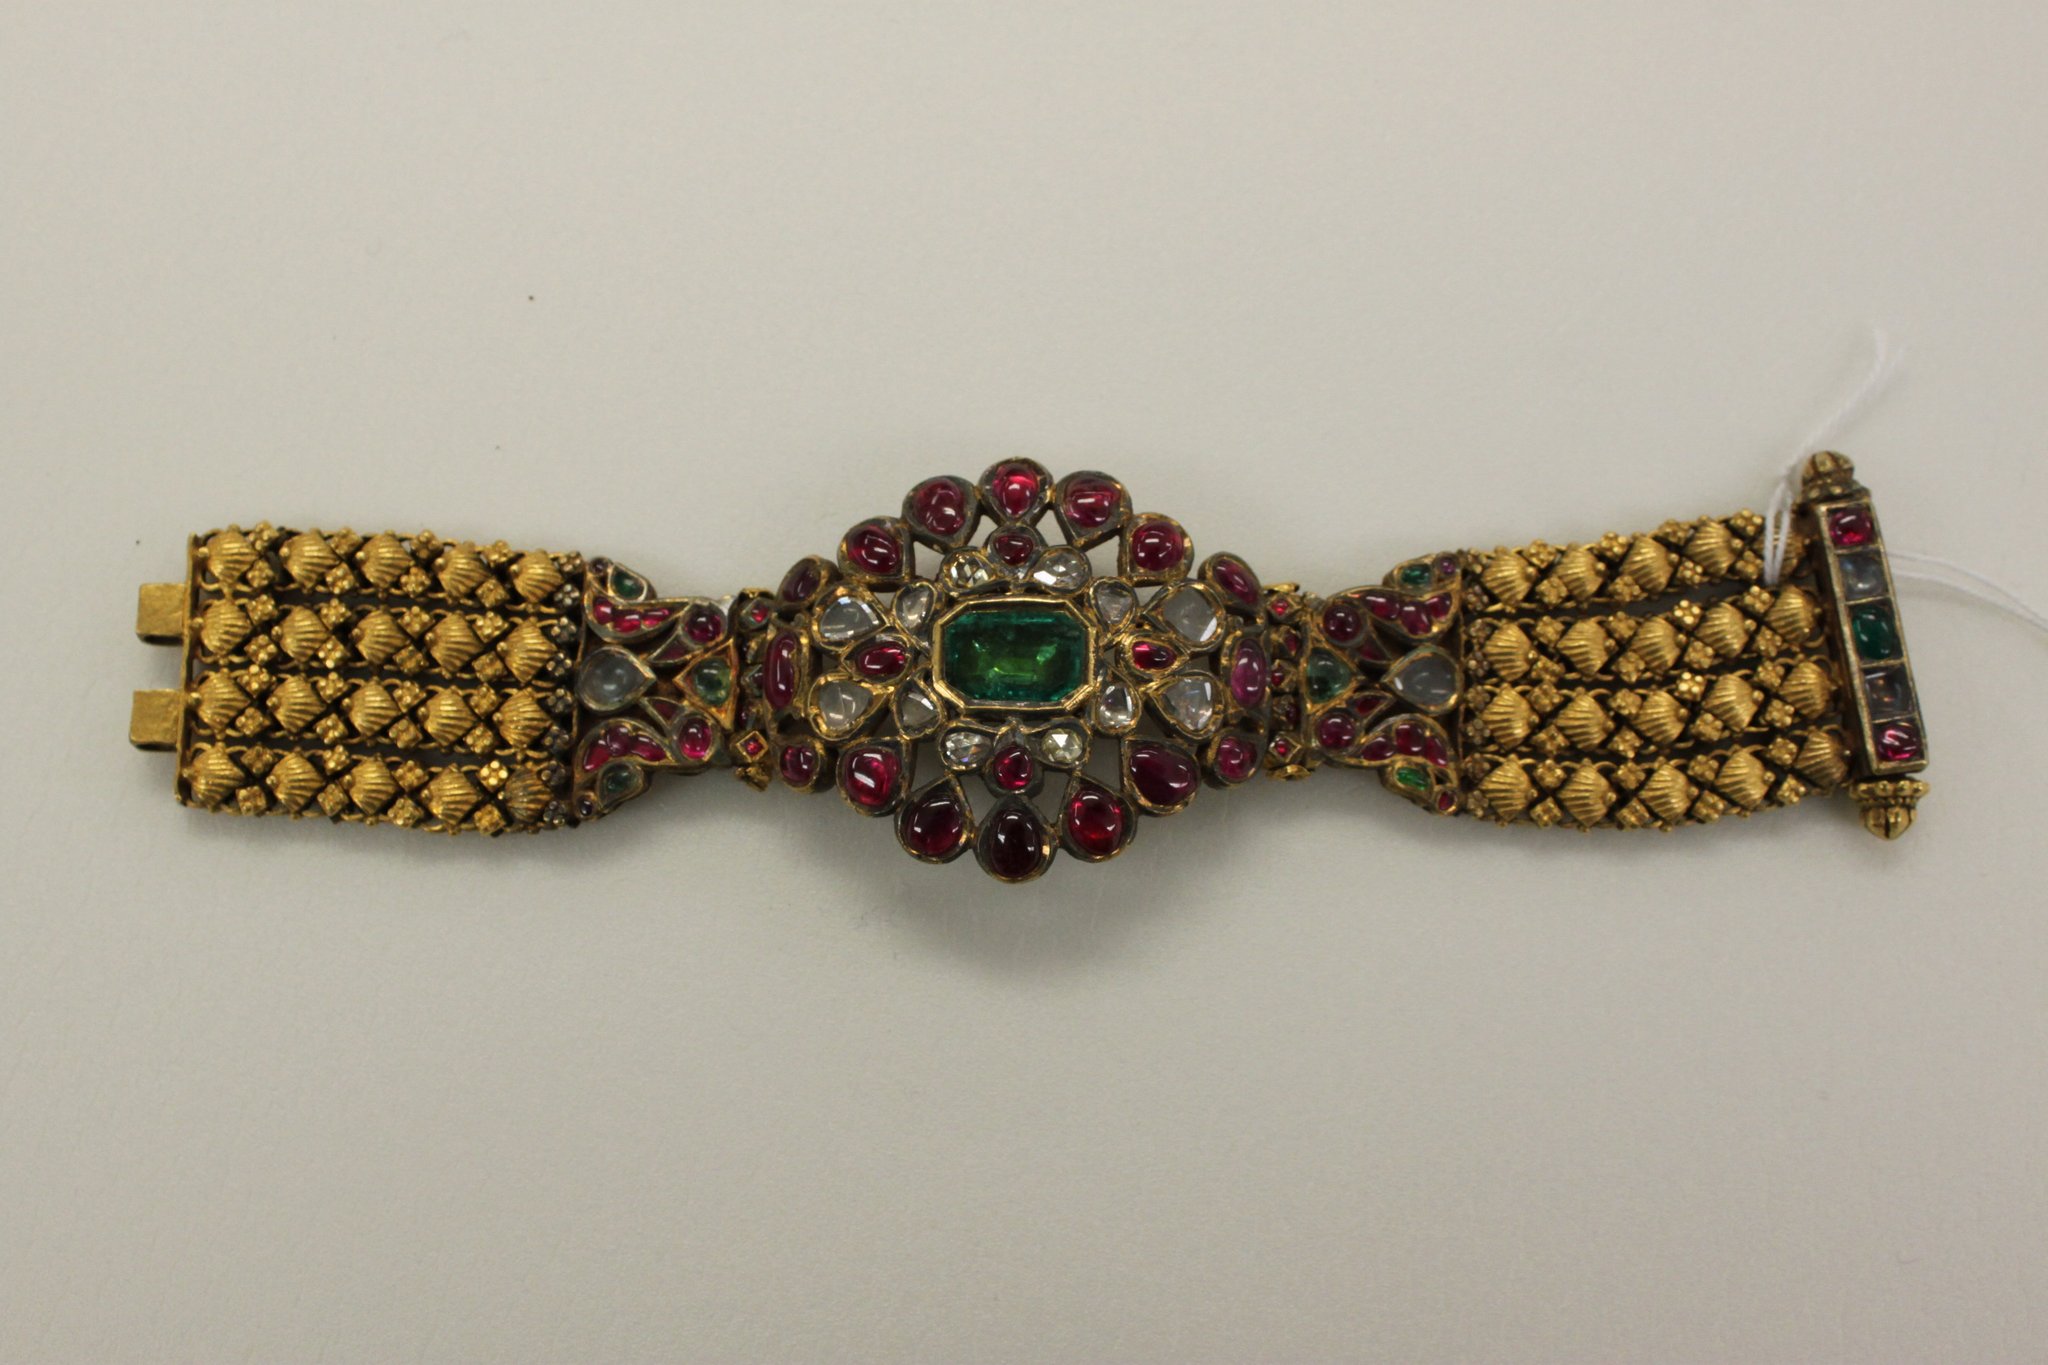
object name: armlet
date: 1701-1800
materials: diamond, gemstone, gold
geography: india